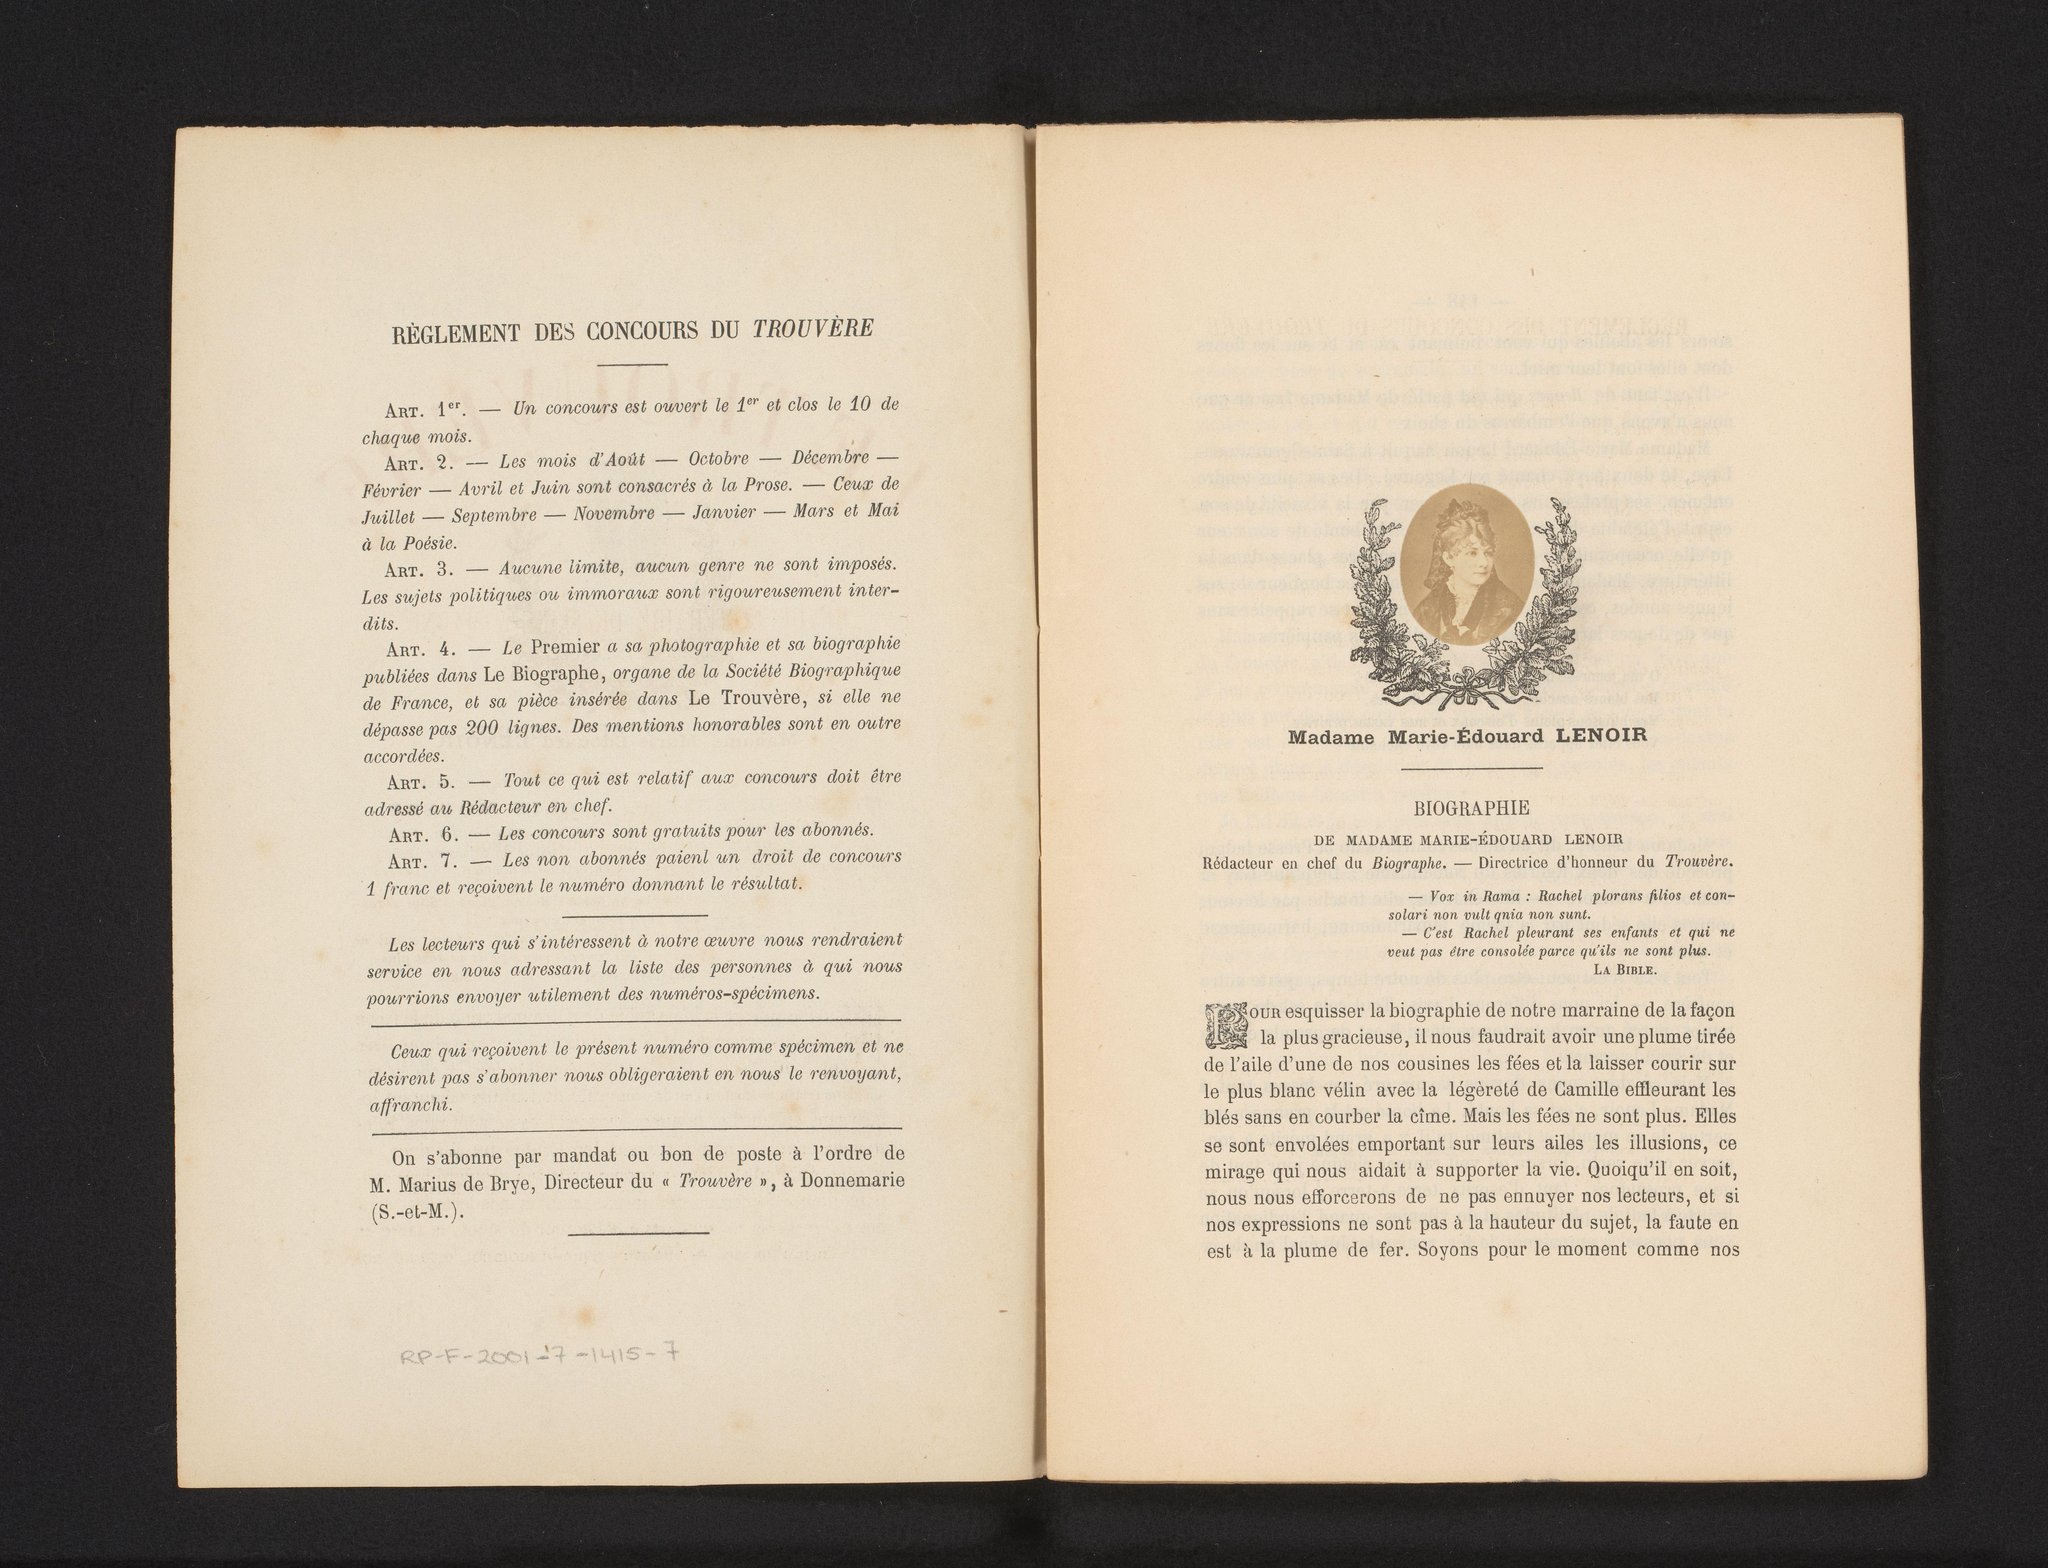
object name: photograph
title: Portret van Marie-Édouard Lenoir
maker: Anonymous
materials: photographic support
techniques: albumen print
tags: marie-édouard lenoir, historical persons - bb - woman